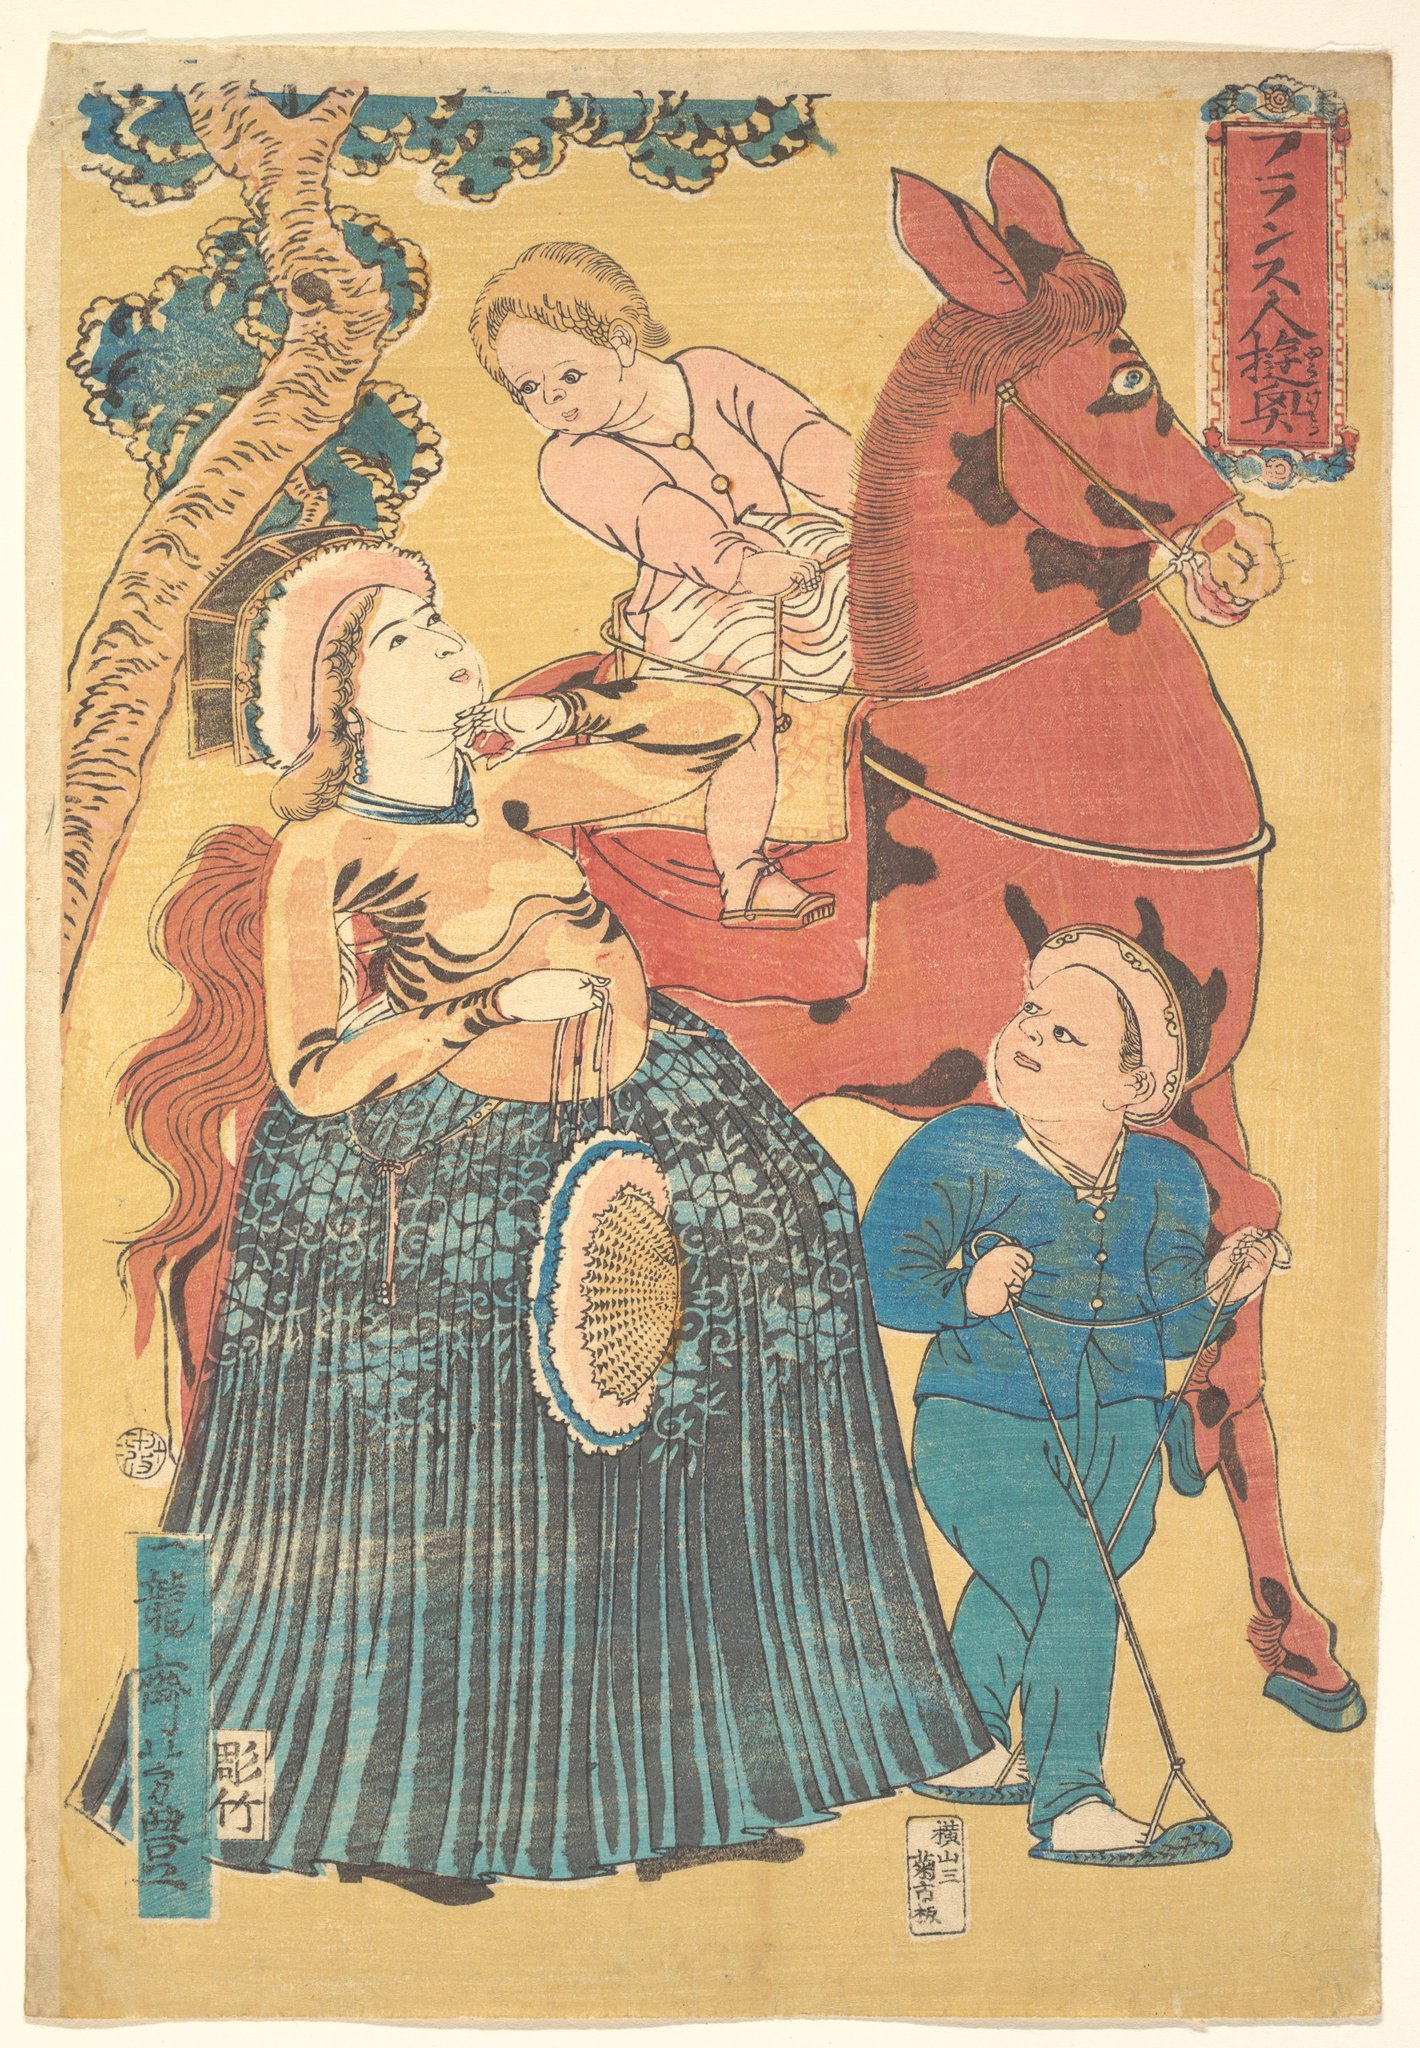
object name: print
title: French Pastimes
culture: japanese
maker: ichiryūsai yoshitoyo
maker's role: artist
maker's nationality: japanese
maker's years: 1830-1866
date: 1860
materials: ink, paper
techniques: woodblock print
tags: boys,girls,women,horses